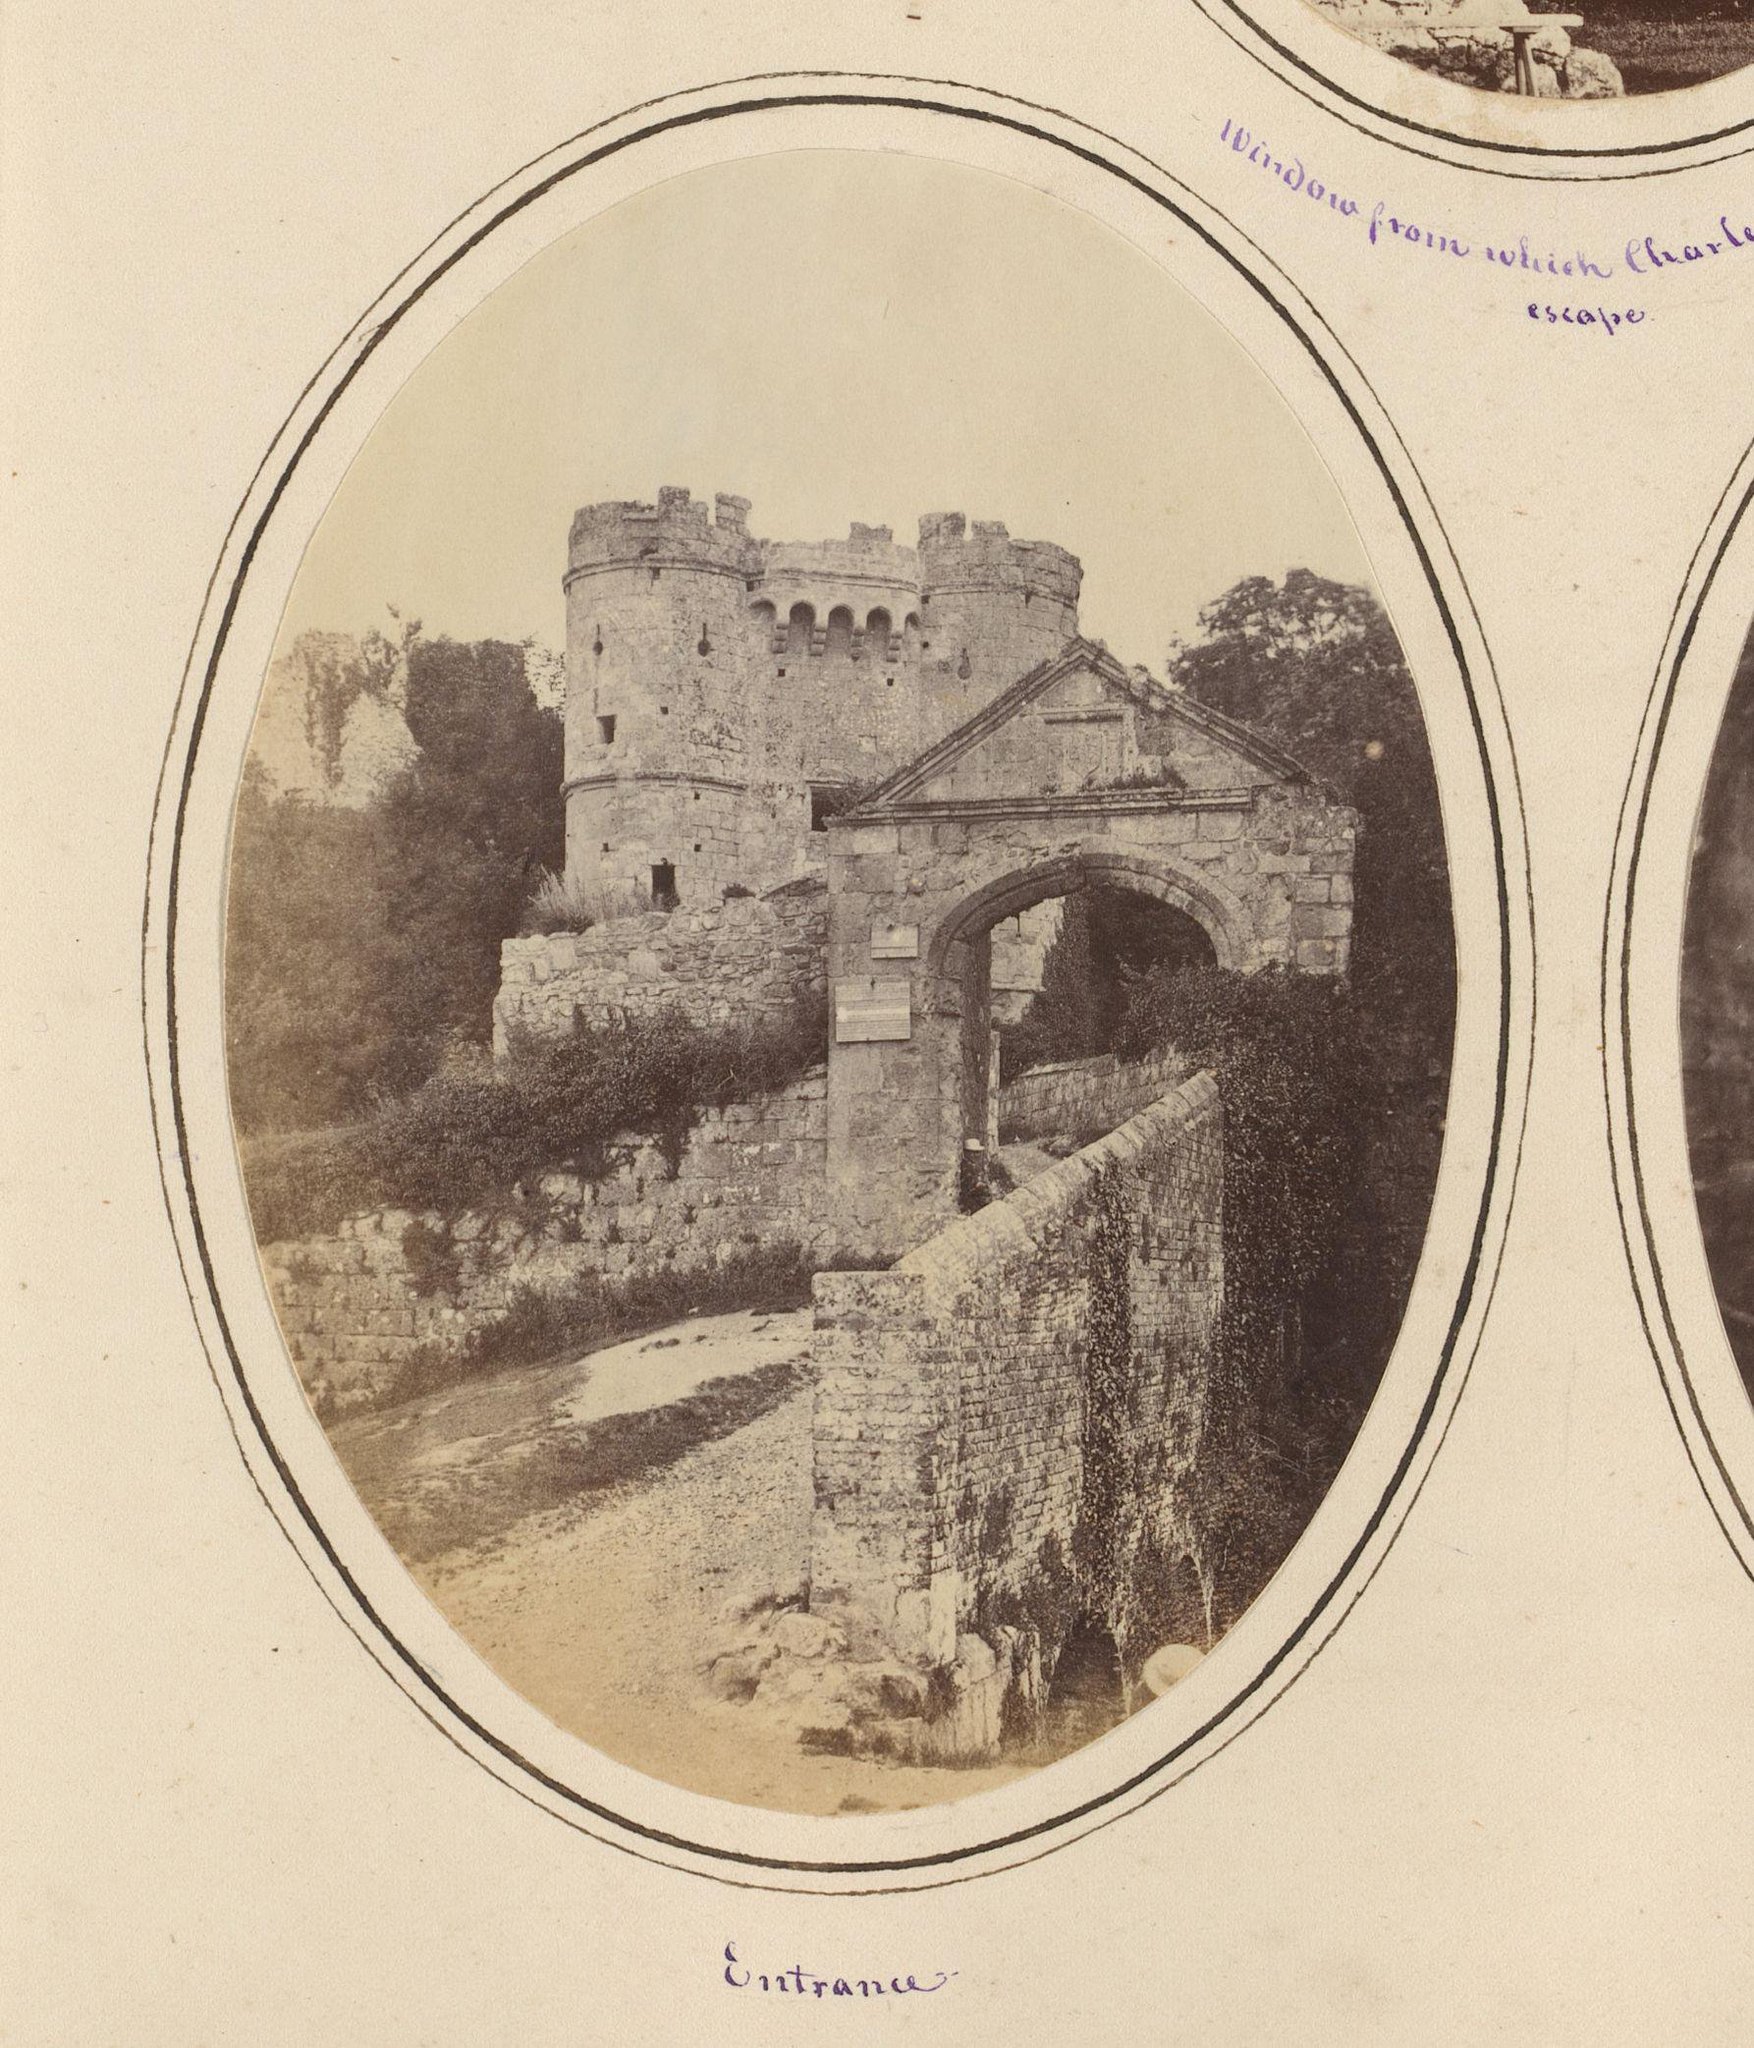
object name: photograph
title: Toegangspoort van Carisbrooke Castle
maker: Anonymous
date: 1870-1890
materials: paper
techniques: albumen print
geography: carisbrooke castle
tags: castle, gate, entrance